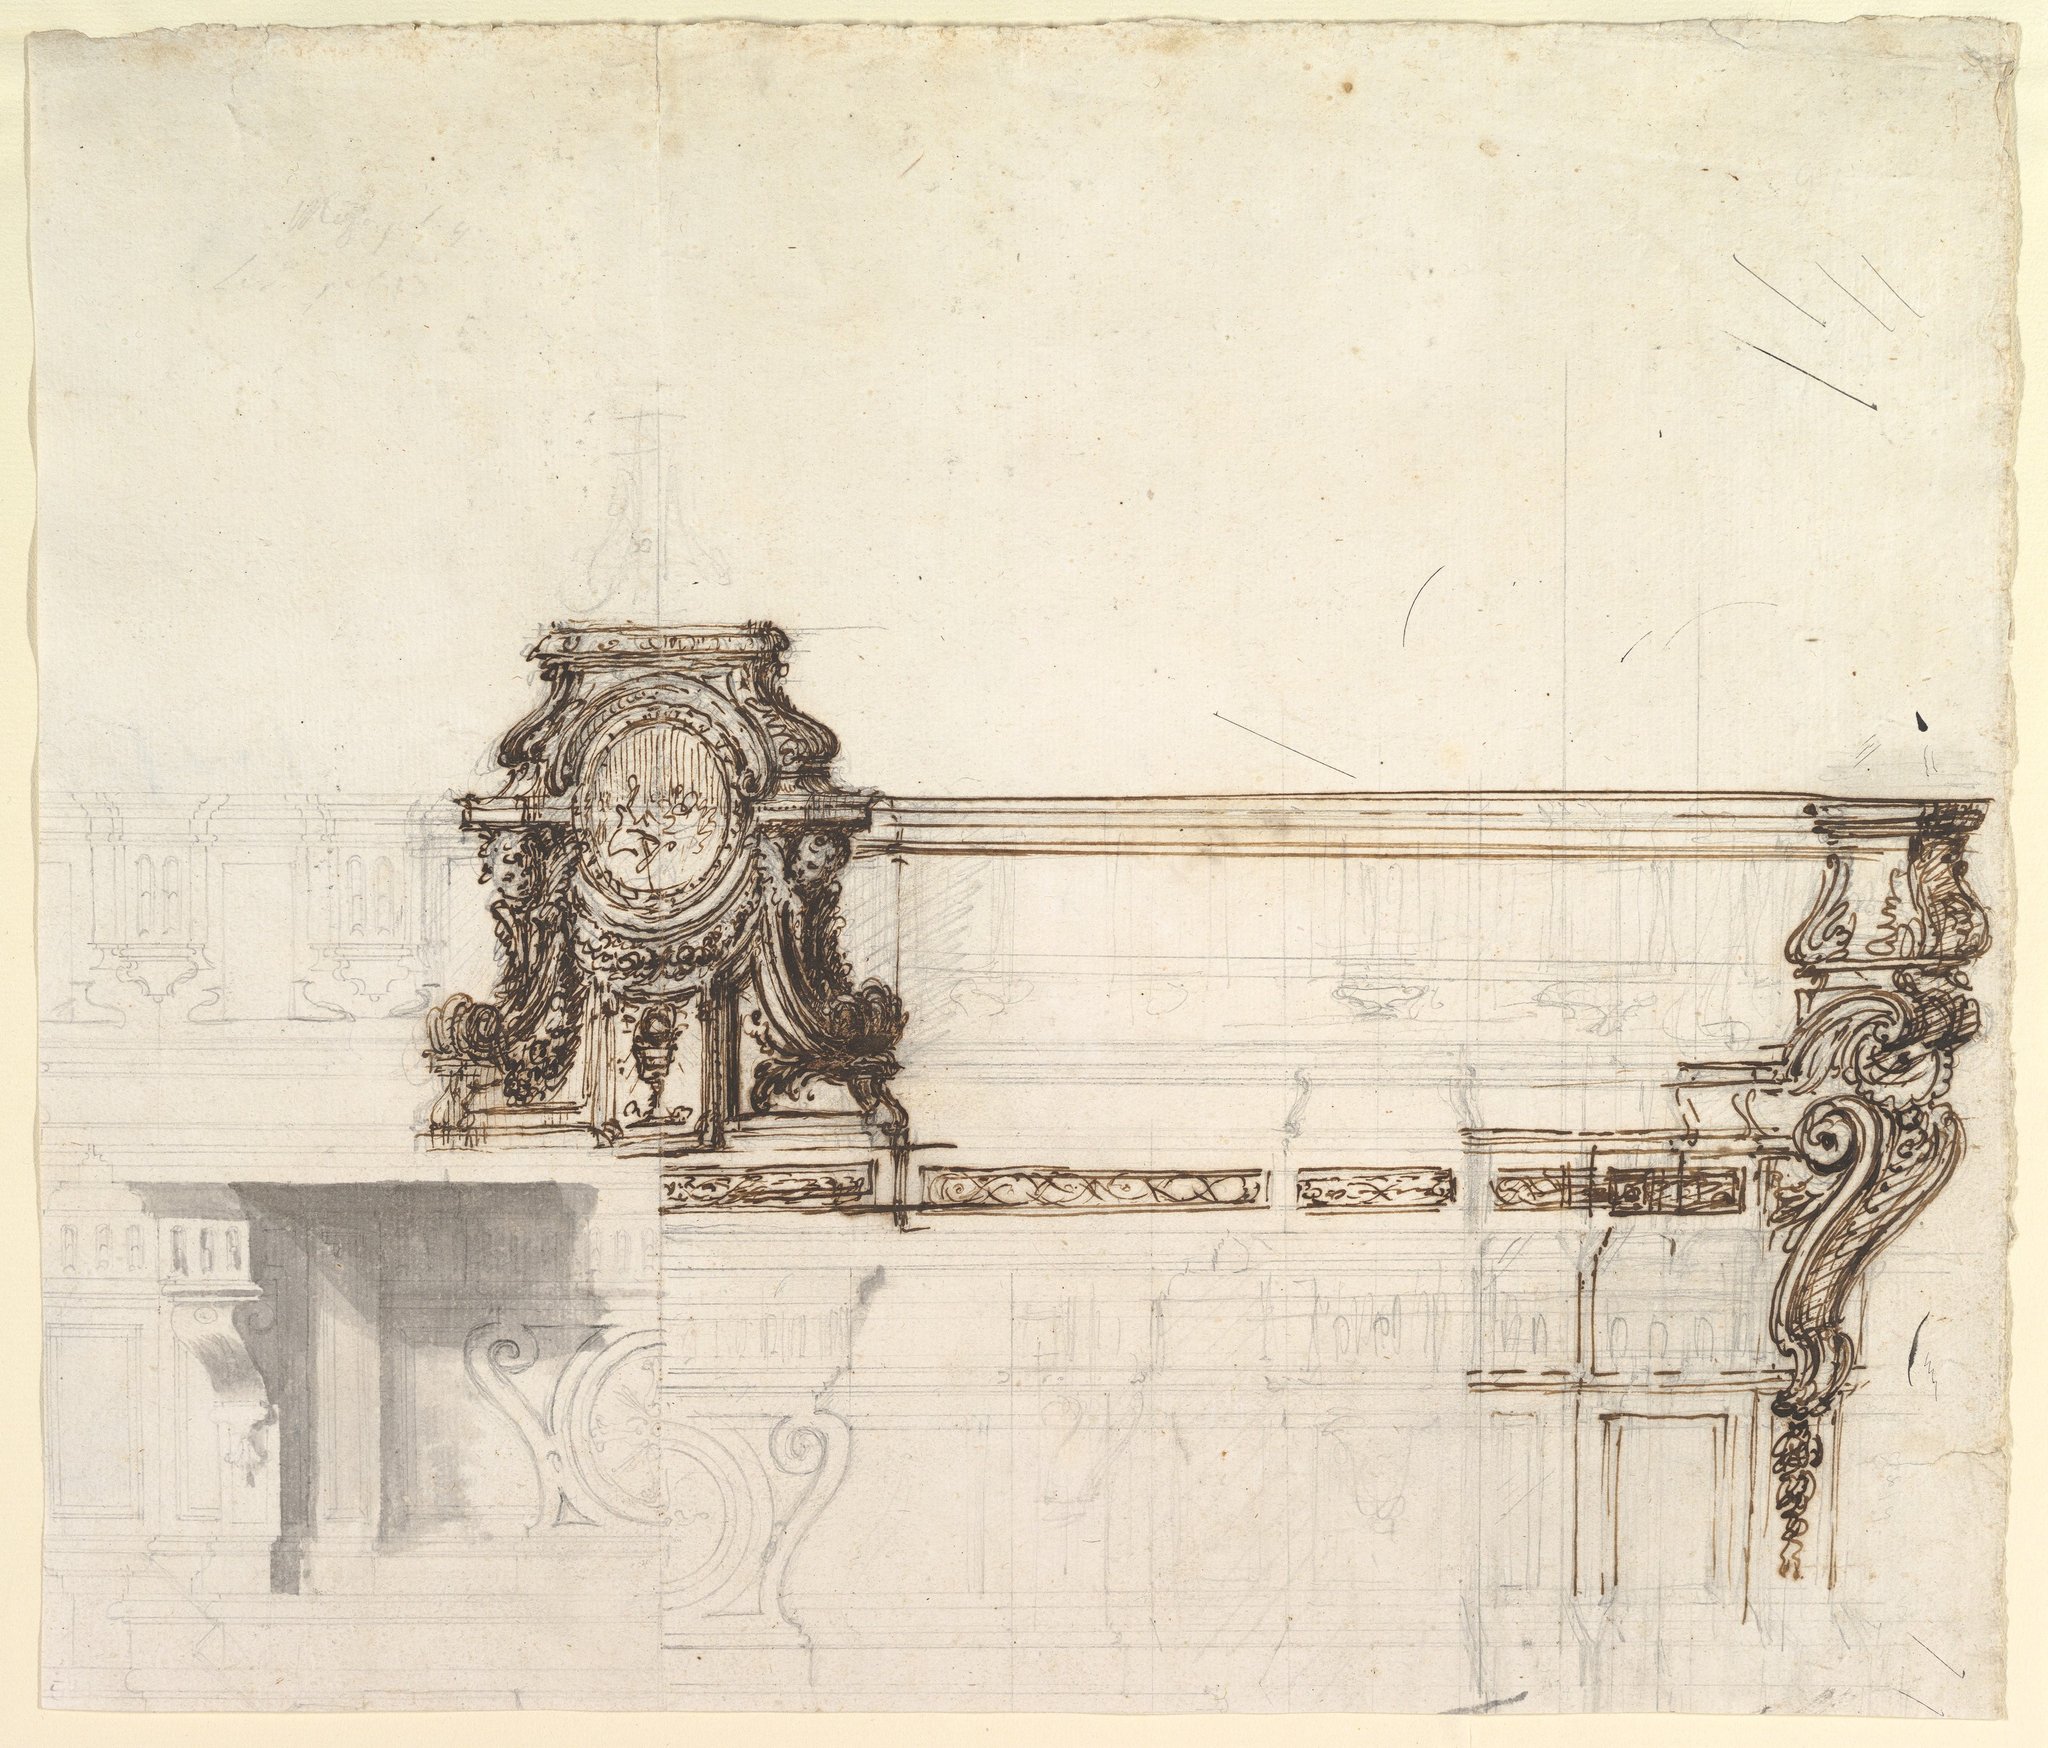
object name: drawing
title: Design for an Altar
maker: luigi vanvitelli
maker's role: artist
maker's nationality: italian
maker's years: 1700-1773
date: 1700-1773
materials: graphite, ink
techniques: brush, pen, wash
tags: altars